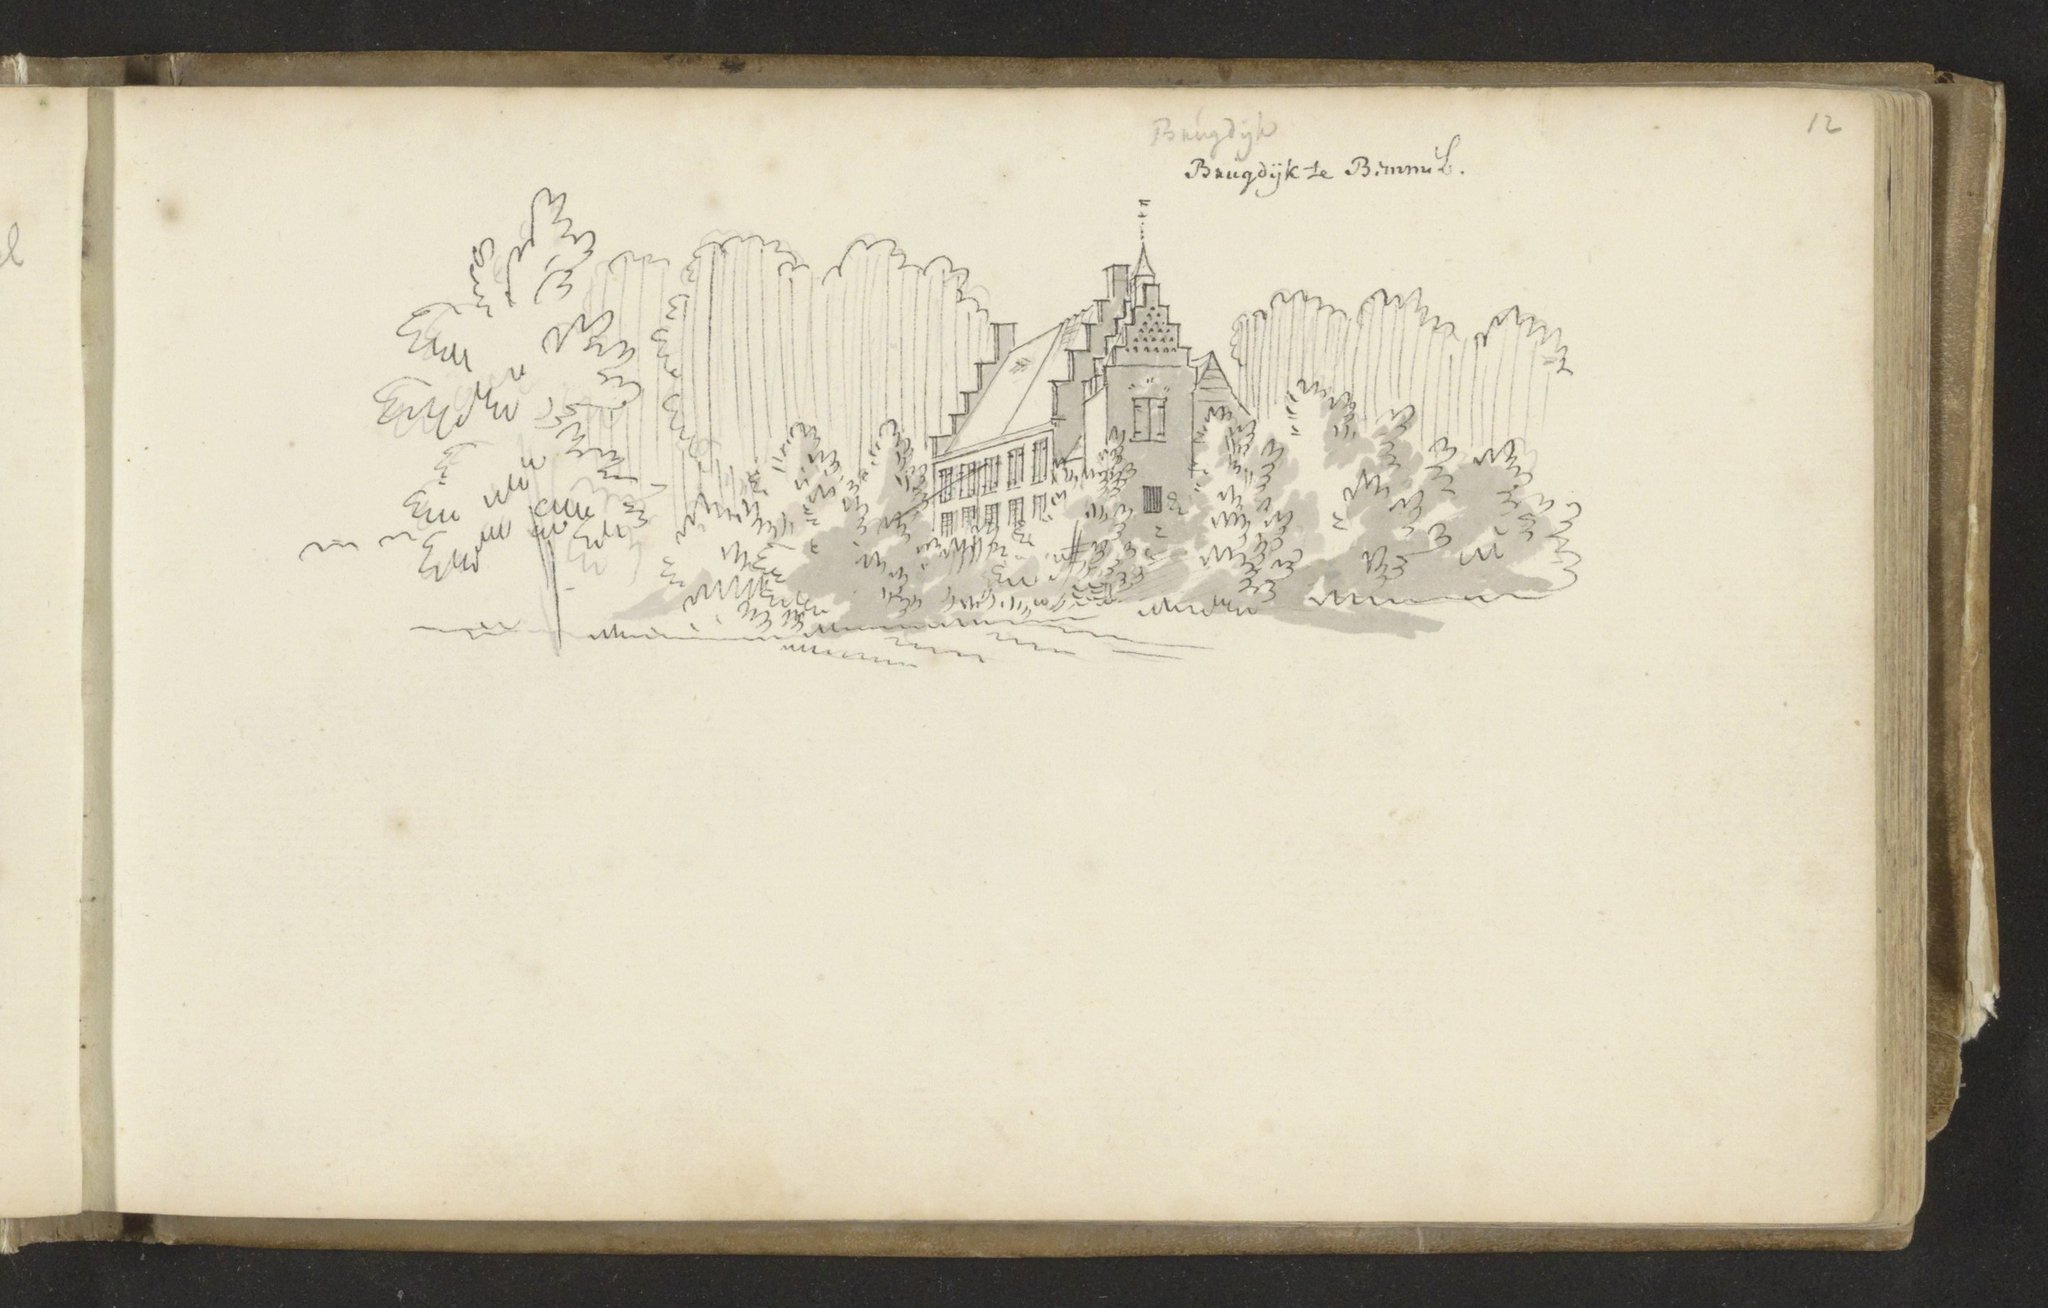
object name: sketchbook leaf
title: Huis Brugdijk te Bemmel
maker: abraham de haen (ii)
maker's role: draughtsman, print maker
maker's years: 1707-1748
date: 1731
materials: ink, paper, pencil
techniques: brush, pen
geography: bemmel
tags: castle, farm or solitary house in landscape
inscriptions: annotation: ‘Brugdijk te Bemmel/ of Brugeijk’, annotation: ‘Brugdijk/ Brugdijk te Bemmel.’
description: Blad 12 recto uit een schetsboek met 69 bladen.